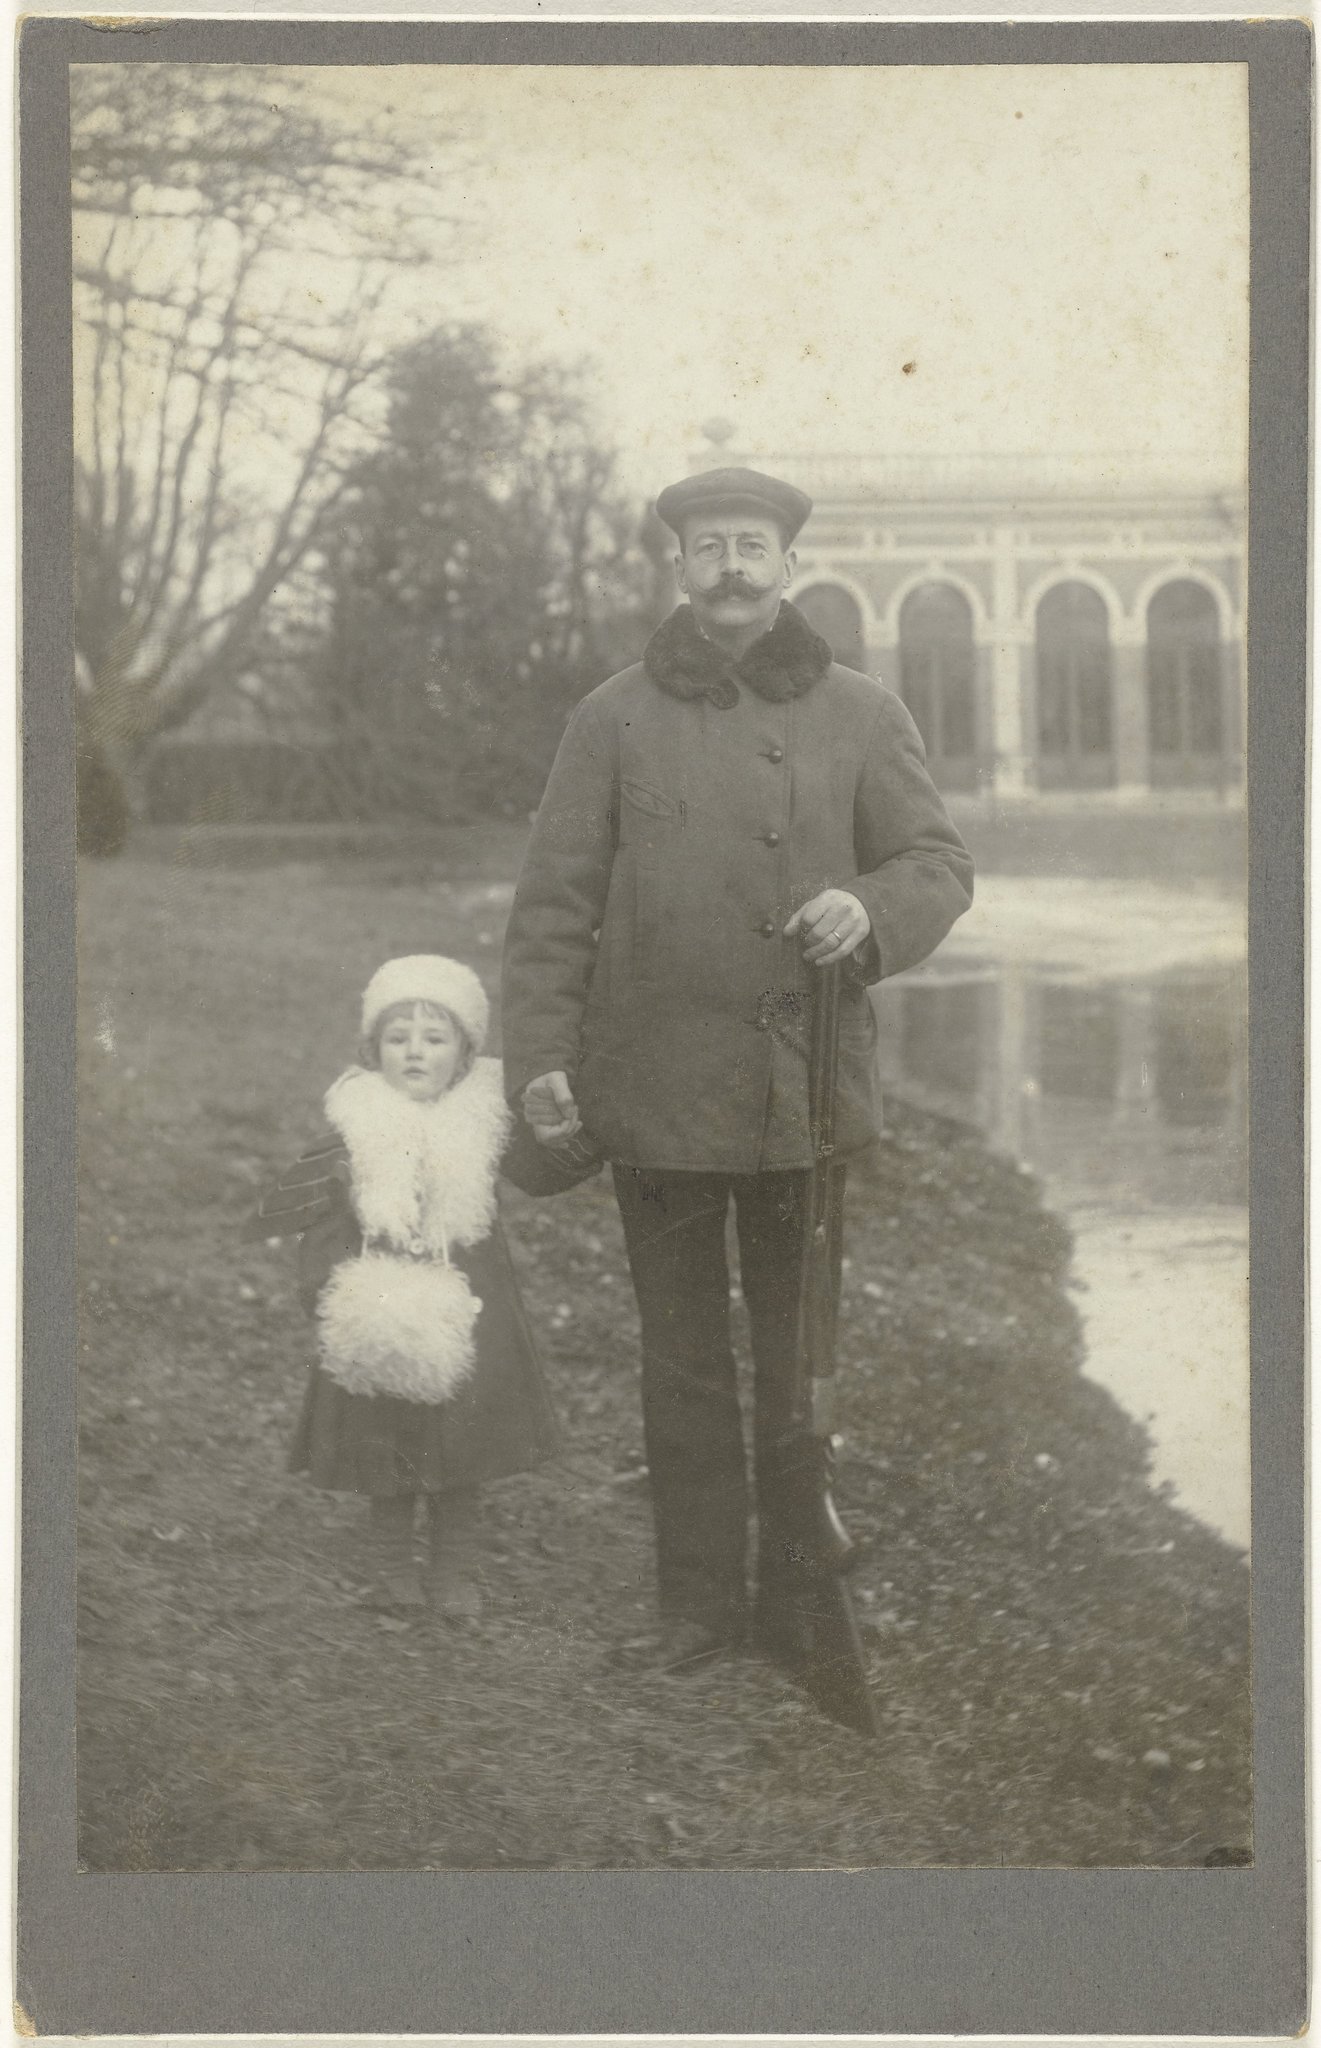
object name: photograph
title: Portret van Henry Pauw van Wieldrecht met zijn oudste dochter Sacha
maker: adriana johanna pauw van wieldrecht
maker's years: 1865-1936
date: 1901-1906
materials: cardboard, photographic support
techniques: gelatin silver print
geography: netherlands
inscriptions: annotation: ‘Daddy / + Sacha’, signature and date: ‘J. Pauw fecit/ January 1906’